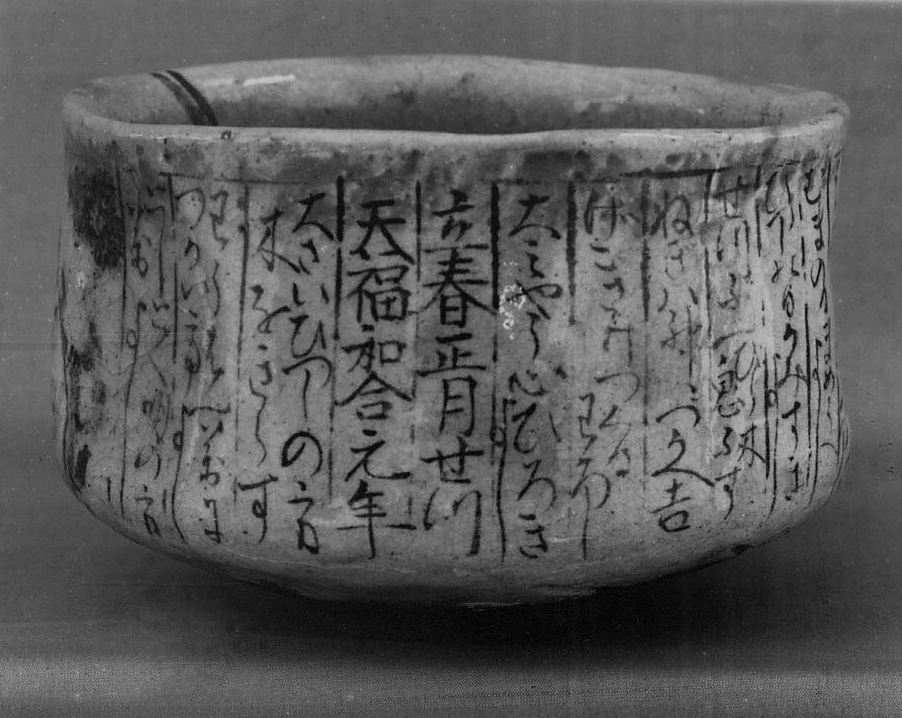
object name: teabowl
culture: japanese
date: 1701-1800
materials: clay, glaze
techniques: writing